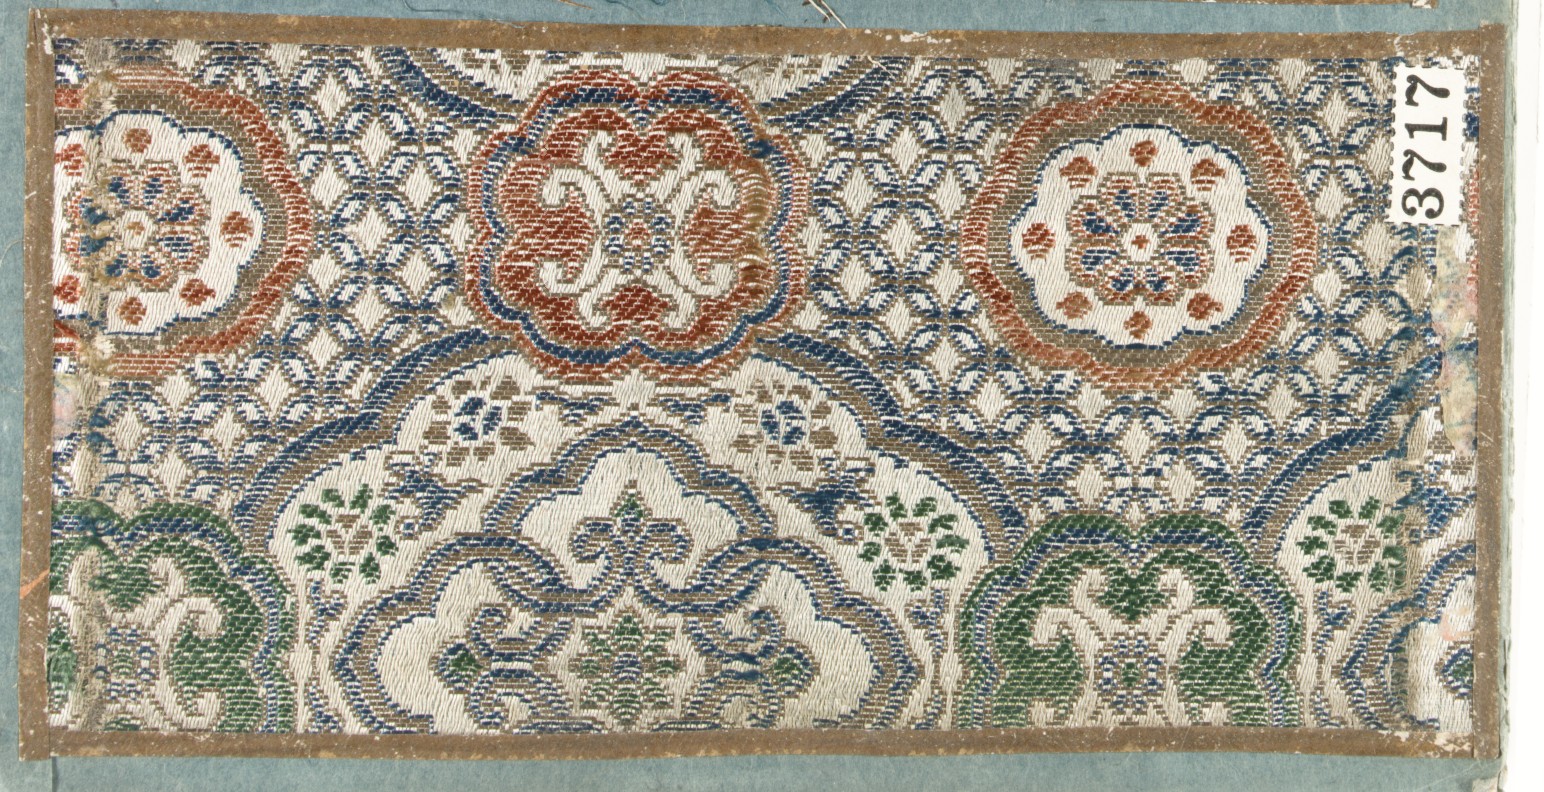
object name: sample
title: Textile Sample from Sample Book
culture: japanese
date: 1801-1900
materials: silk